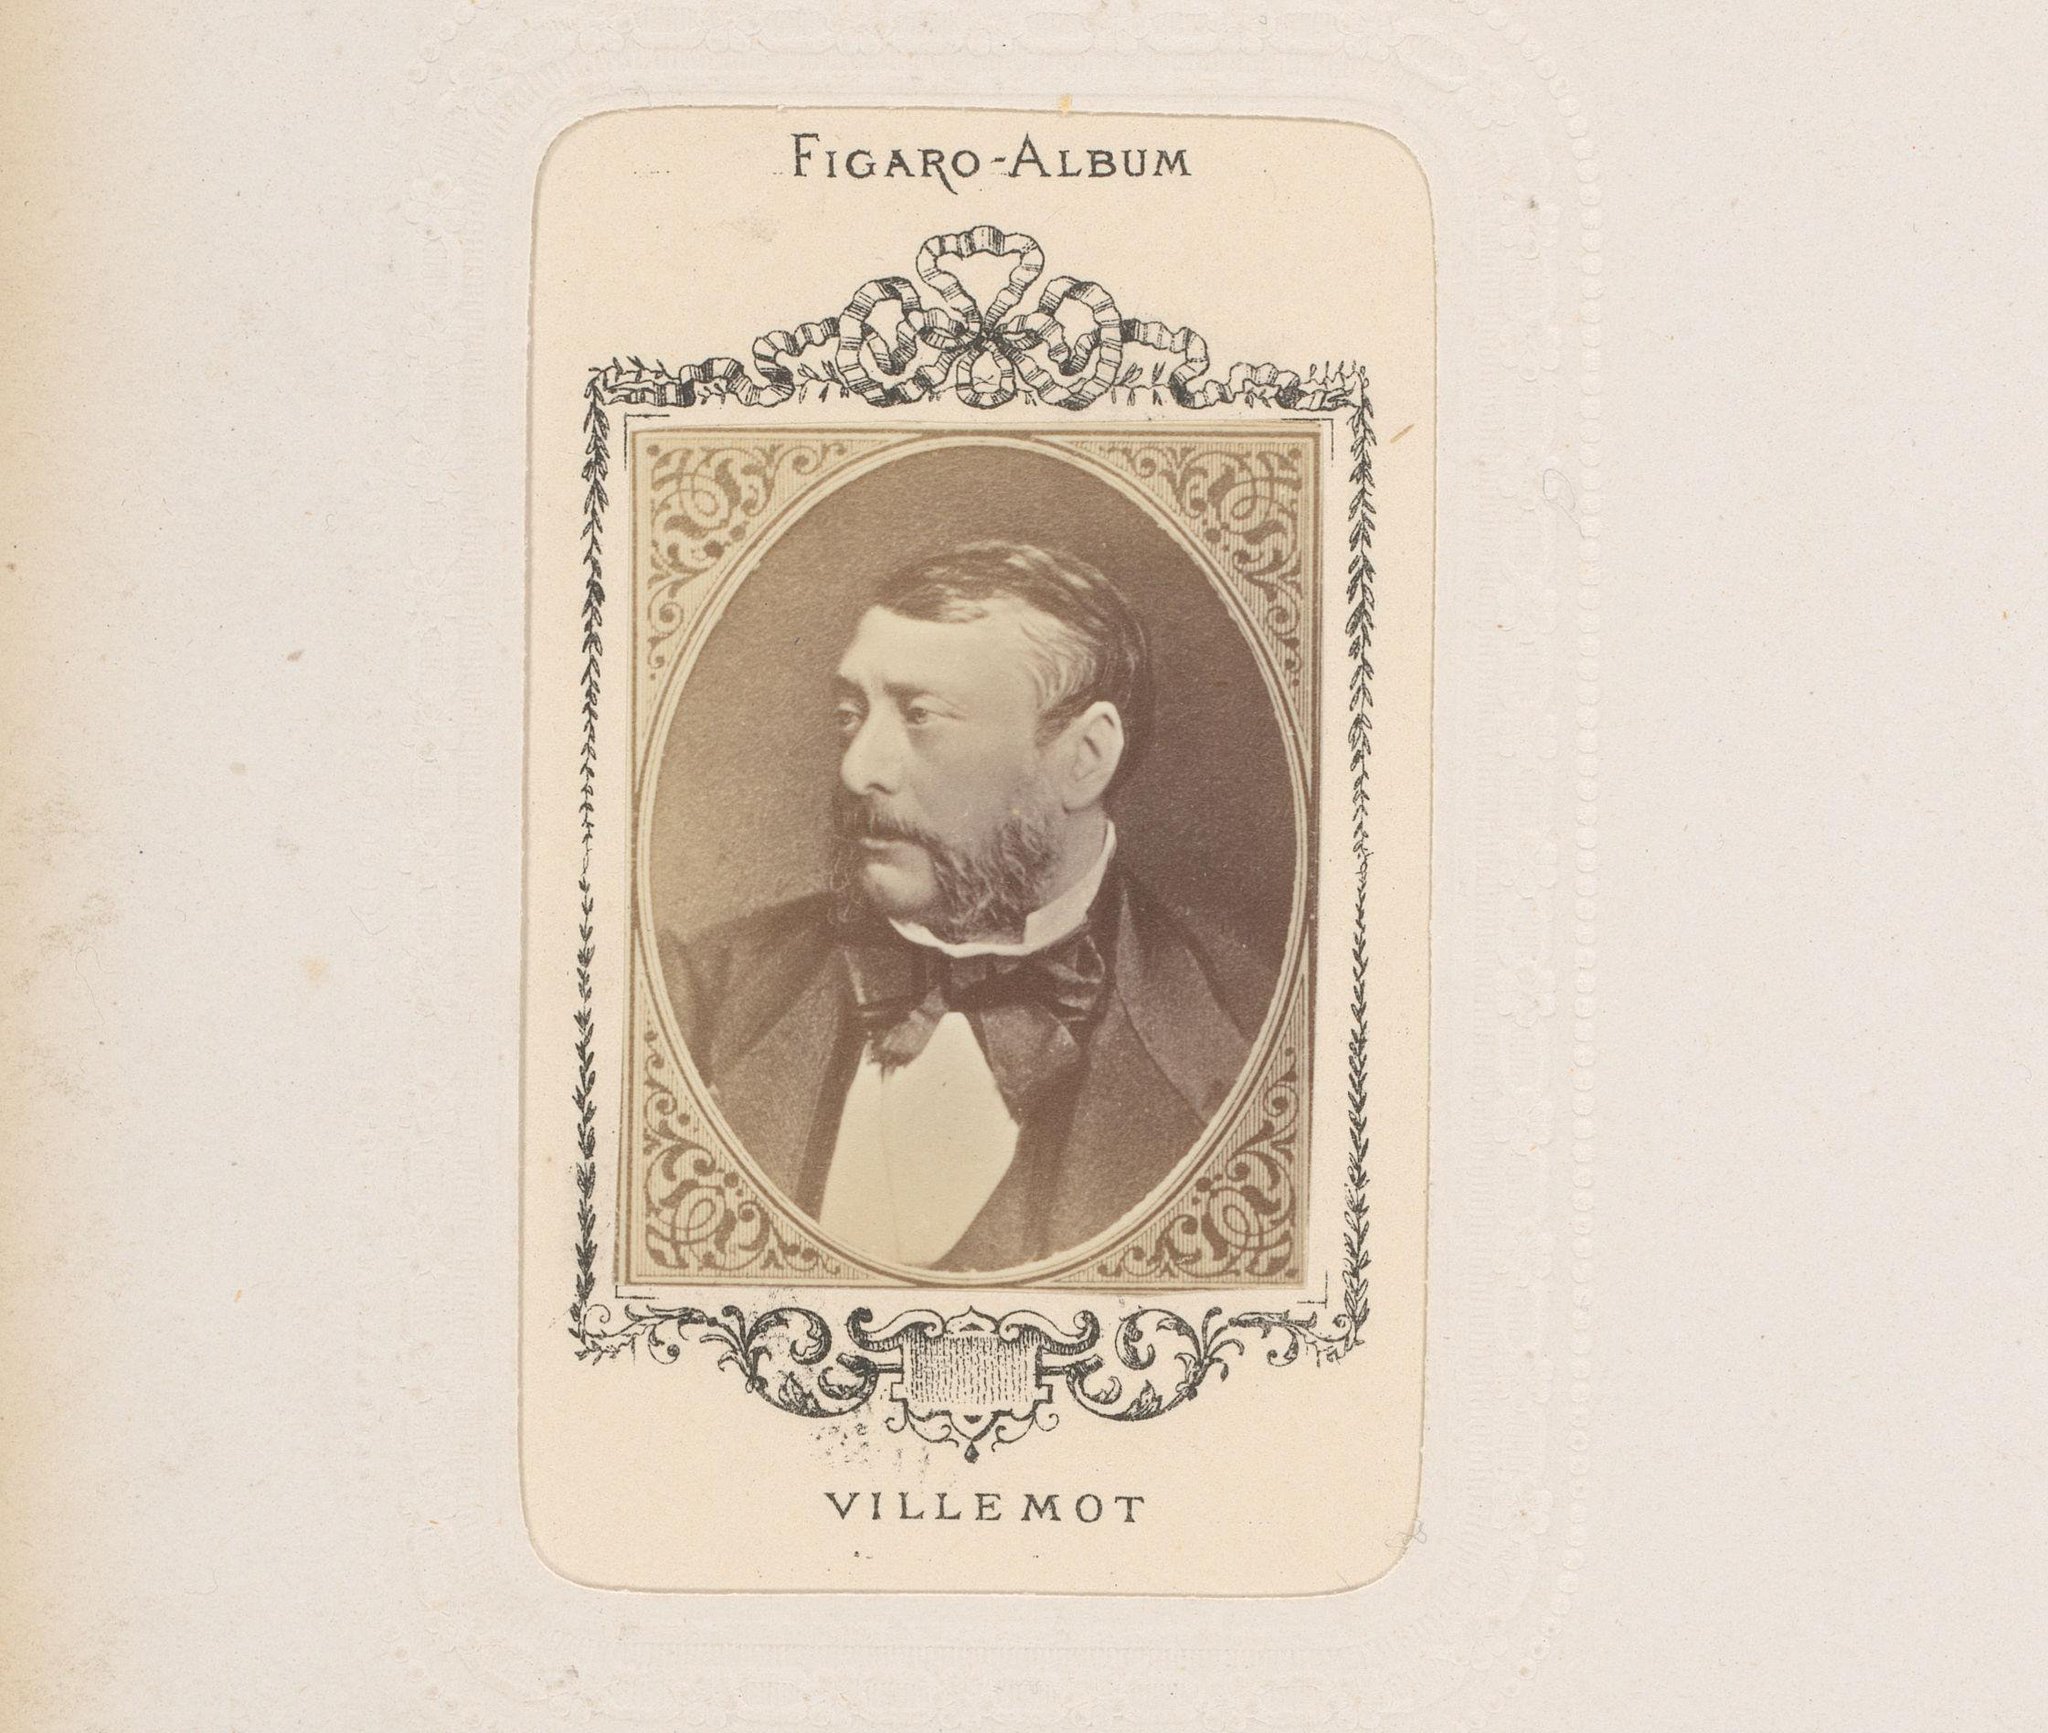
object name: carte de visite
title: Fotoreproductie van een portret van Auguste Villemot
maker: Anonymous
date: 1860-1900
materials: cardboard, photographic support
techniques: albumen print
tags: paris, journalist, reporter, historical persons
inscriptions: inscription: ‘Figaro-Album/ Villemot’